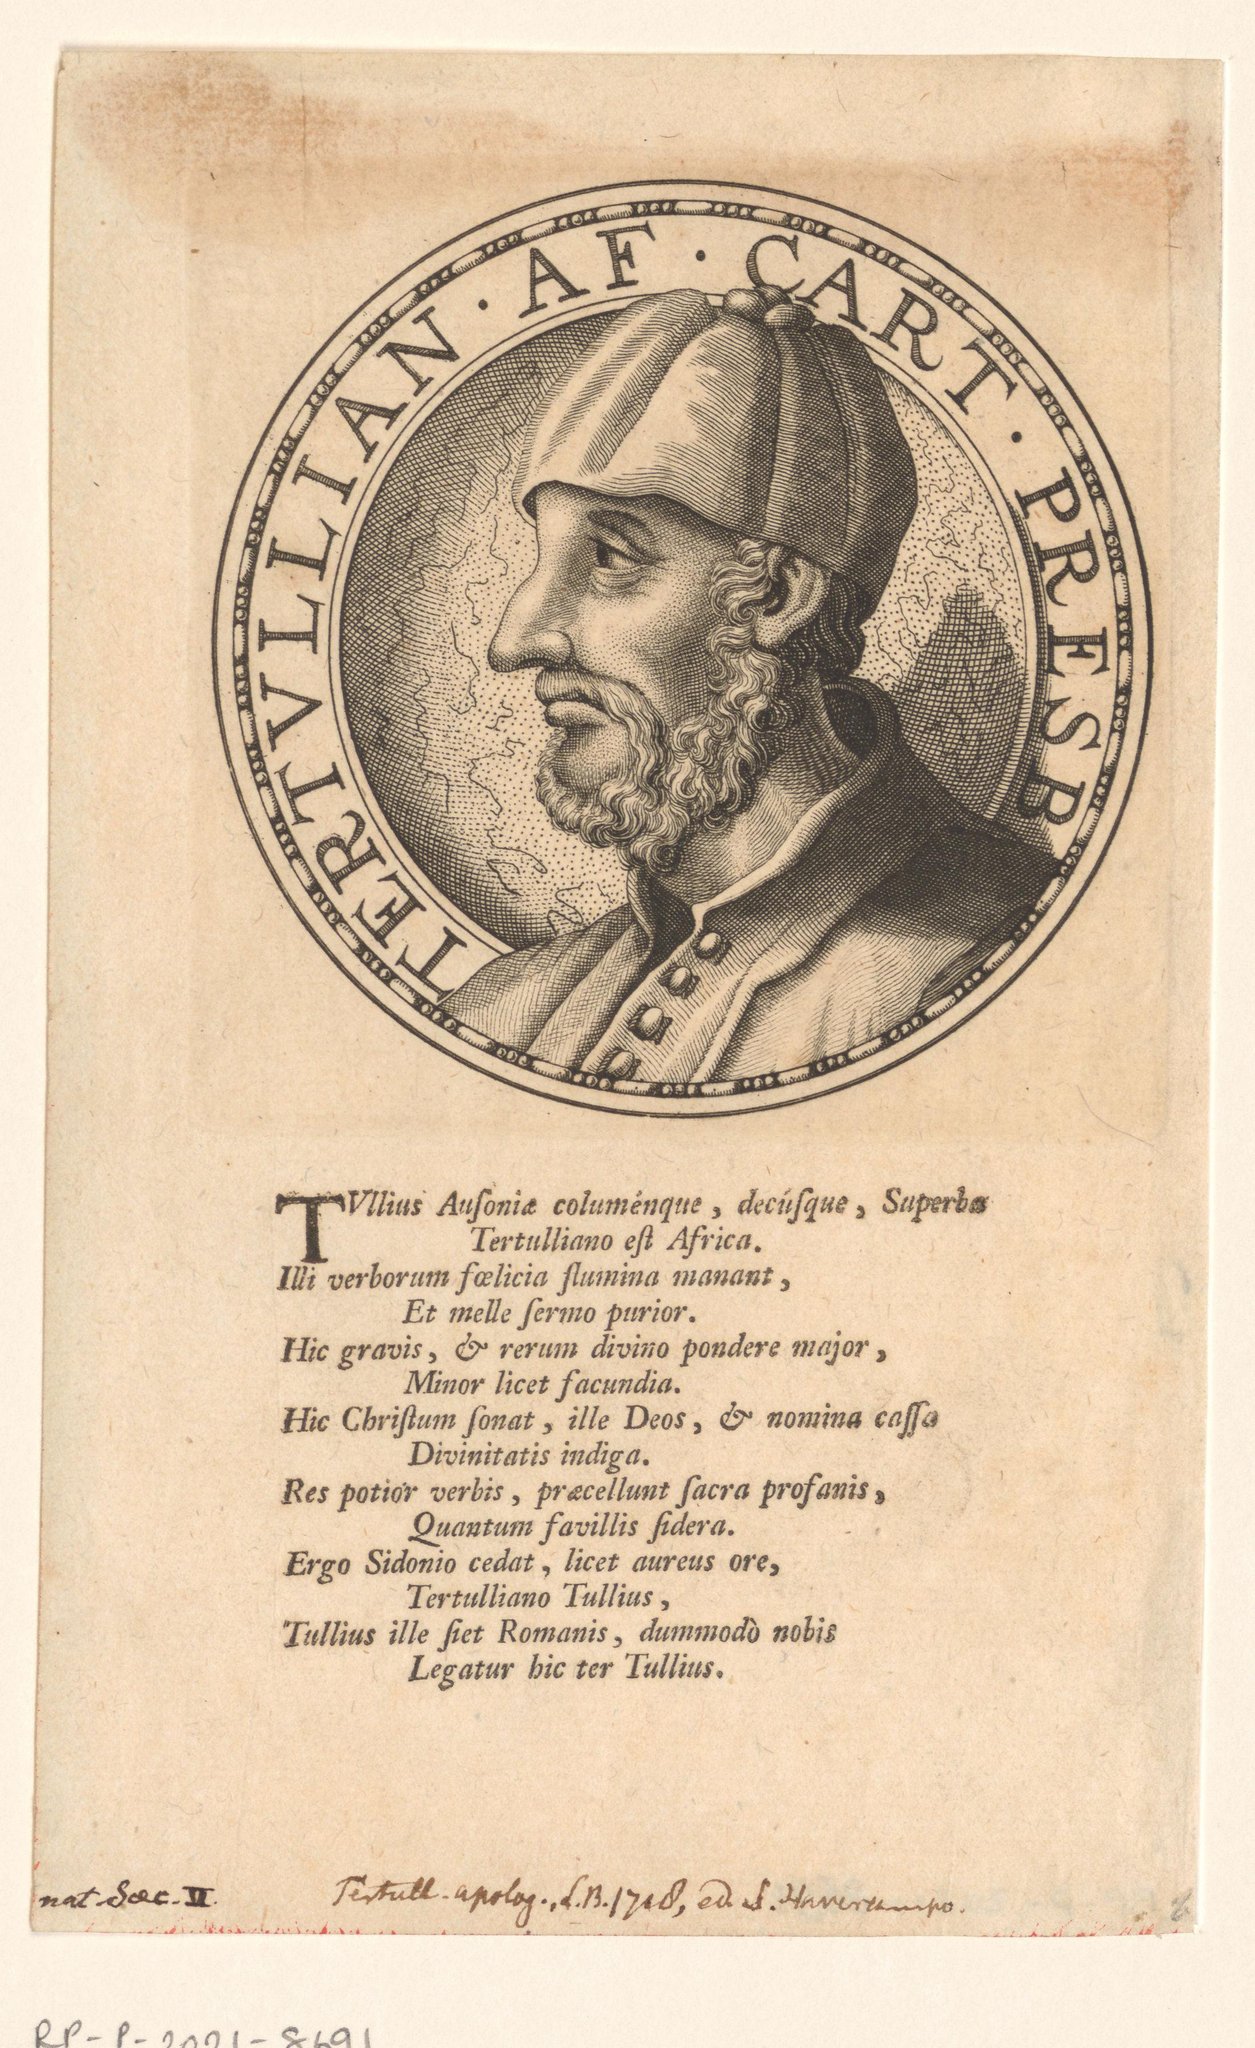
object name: print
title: Portret van Tertullianus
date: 1718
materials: paper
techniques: engraving, etching, letterpress printing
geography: leiden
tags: theologian, historical persons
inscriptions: inscription: ‘nat Sec II. Tertull. Apolog. [...] 1718 (...)’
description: Prent uit: Tertullianus. Apologeticus. Leiden: Isaac Severinus, 1718.